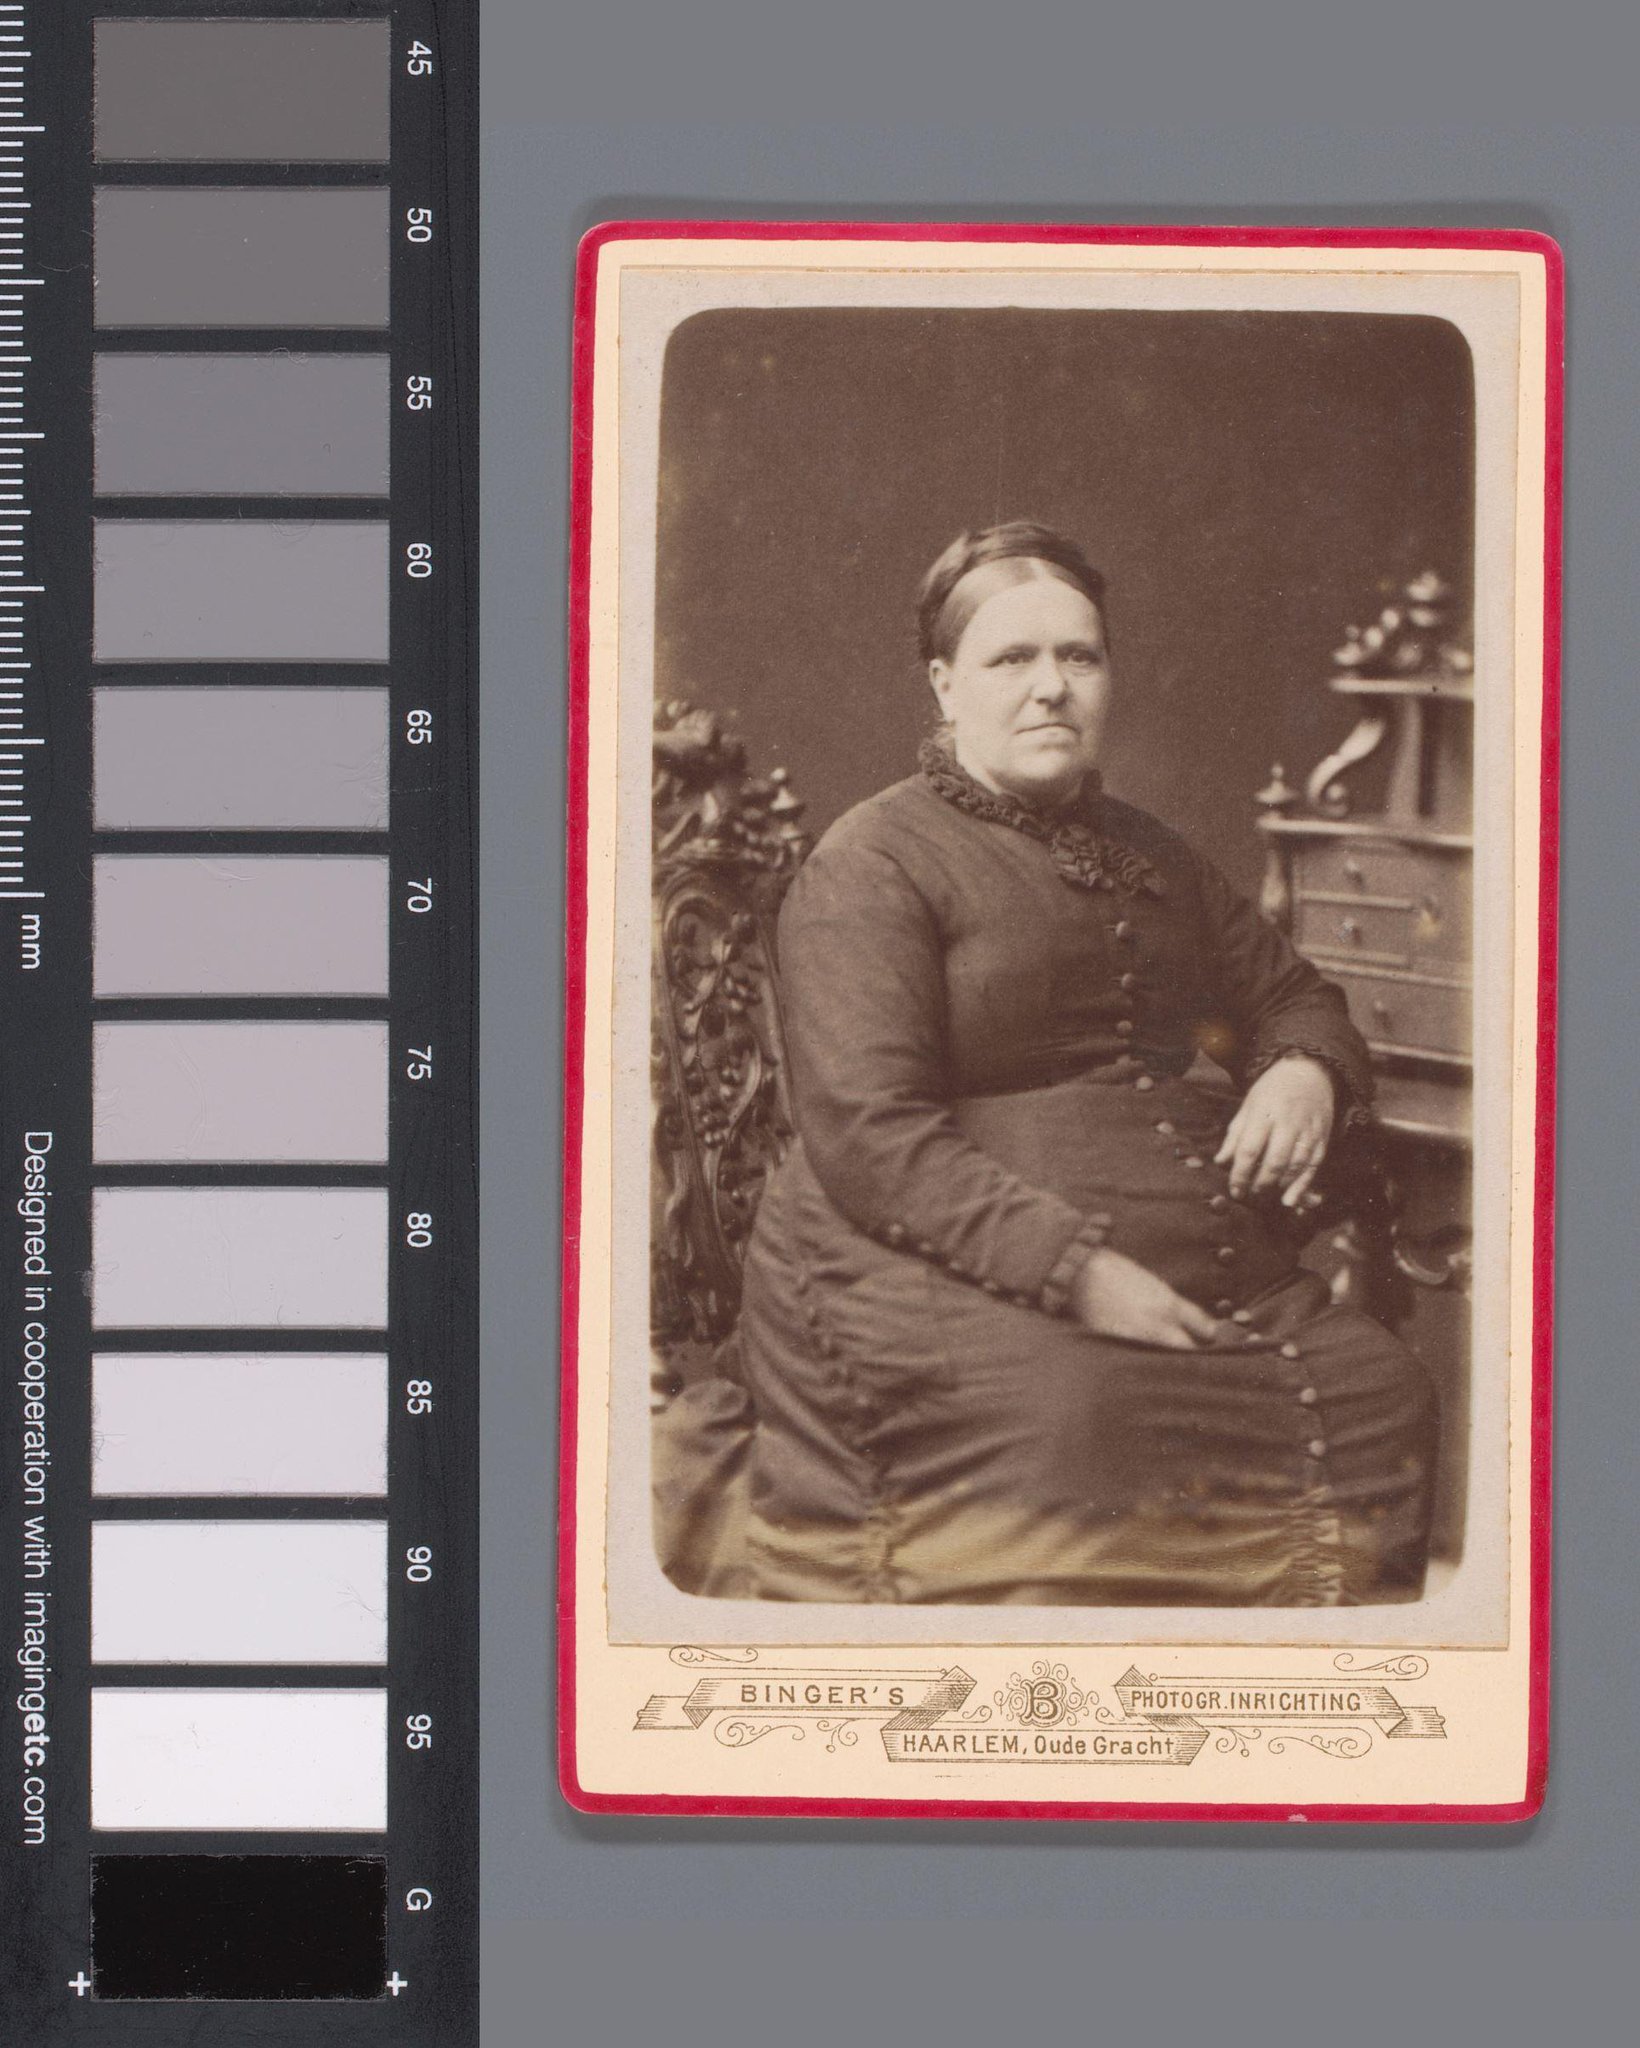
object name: semi enamel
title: Portret van een onbekende vrouw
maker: charles binger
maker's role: print maker, printer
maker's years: 1830-1916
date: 1878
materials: cardboard, celluloid, paper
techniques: albumen print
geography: haarlem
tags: adult woman, anonymous historical person portrayed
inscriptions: inscription: ‘Bekroond/ Groningen/ Weenen.’, address: ‘Oude Gracht/ Haarllem’